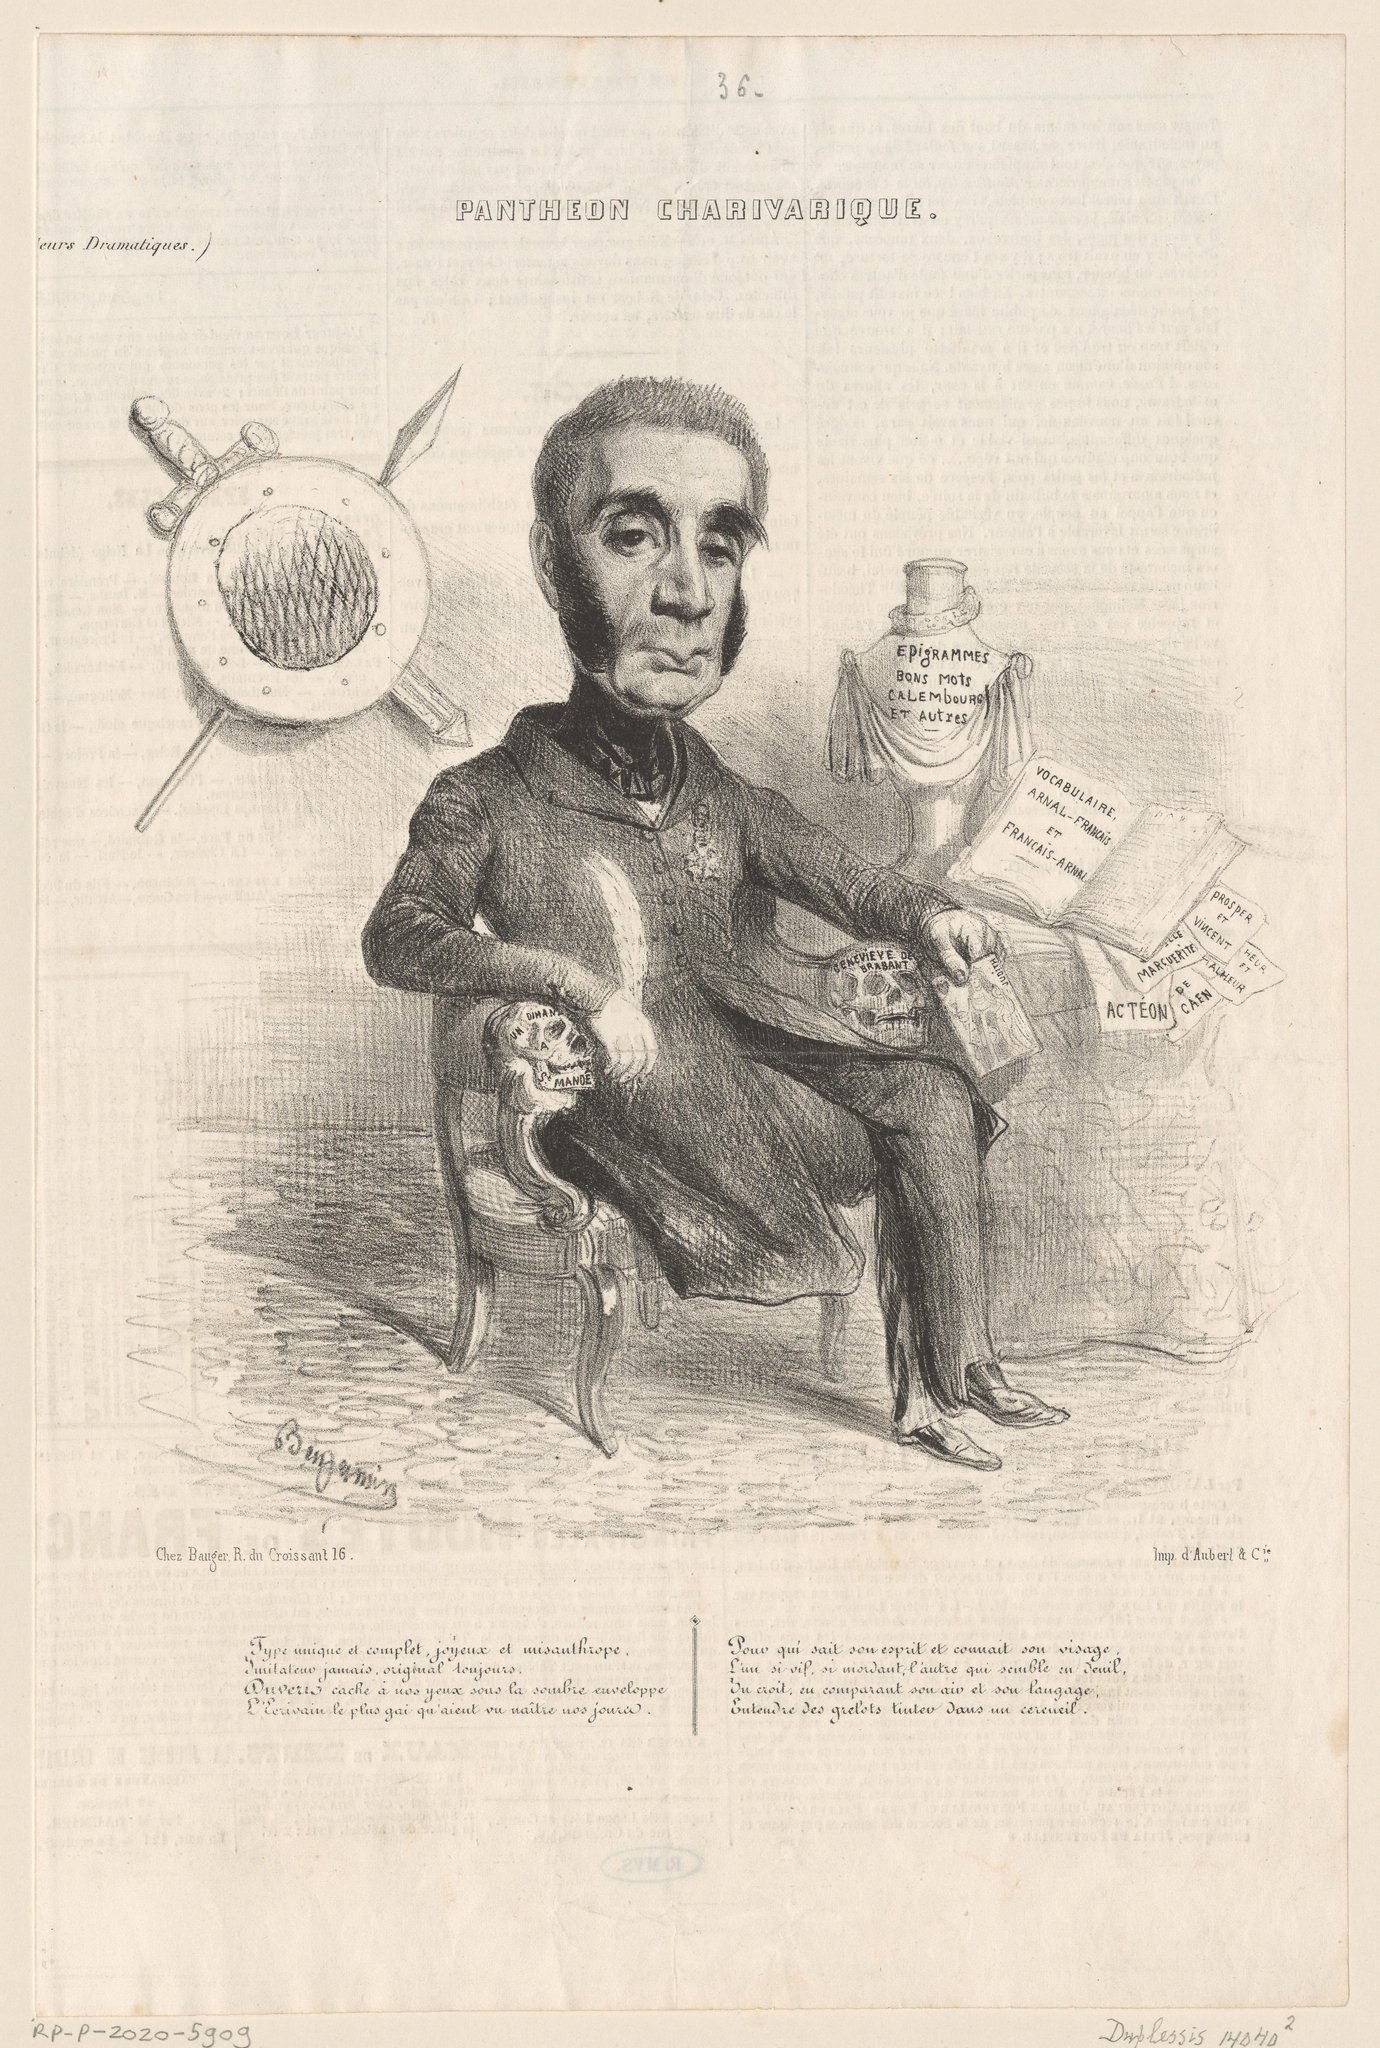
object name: print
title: Panthéon Charivarique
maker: benjamin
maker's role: print maker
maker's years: 1811-1847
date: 1840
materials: paper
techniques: letterpress printing, lithograph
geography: paris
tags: historical persons, portrait of a writer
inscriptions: collector's mark: Lugt 2228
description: Zittend op een stoel, waarvan beide armleuningen zijn voorzien van een schedel. Achter de geportretteerde hangt een schild met een zwaard en speer aan de muur.